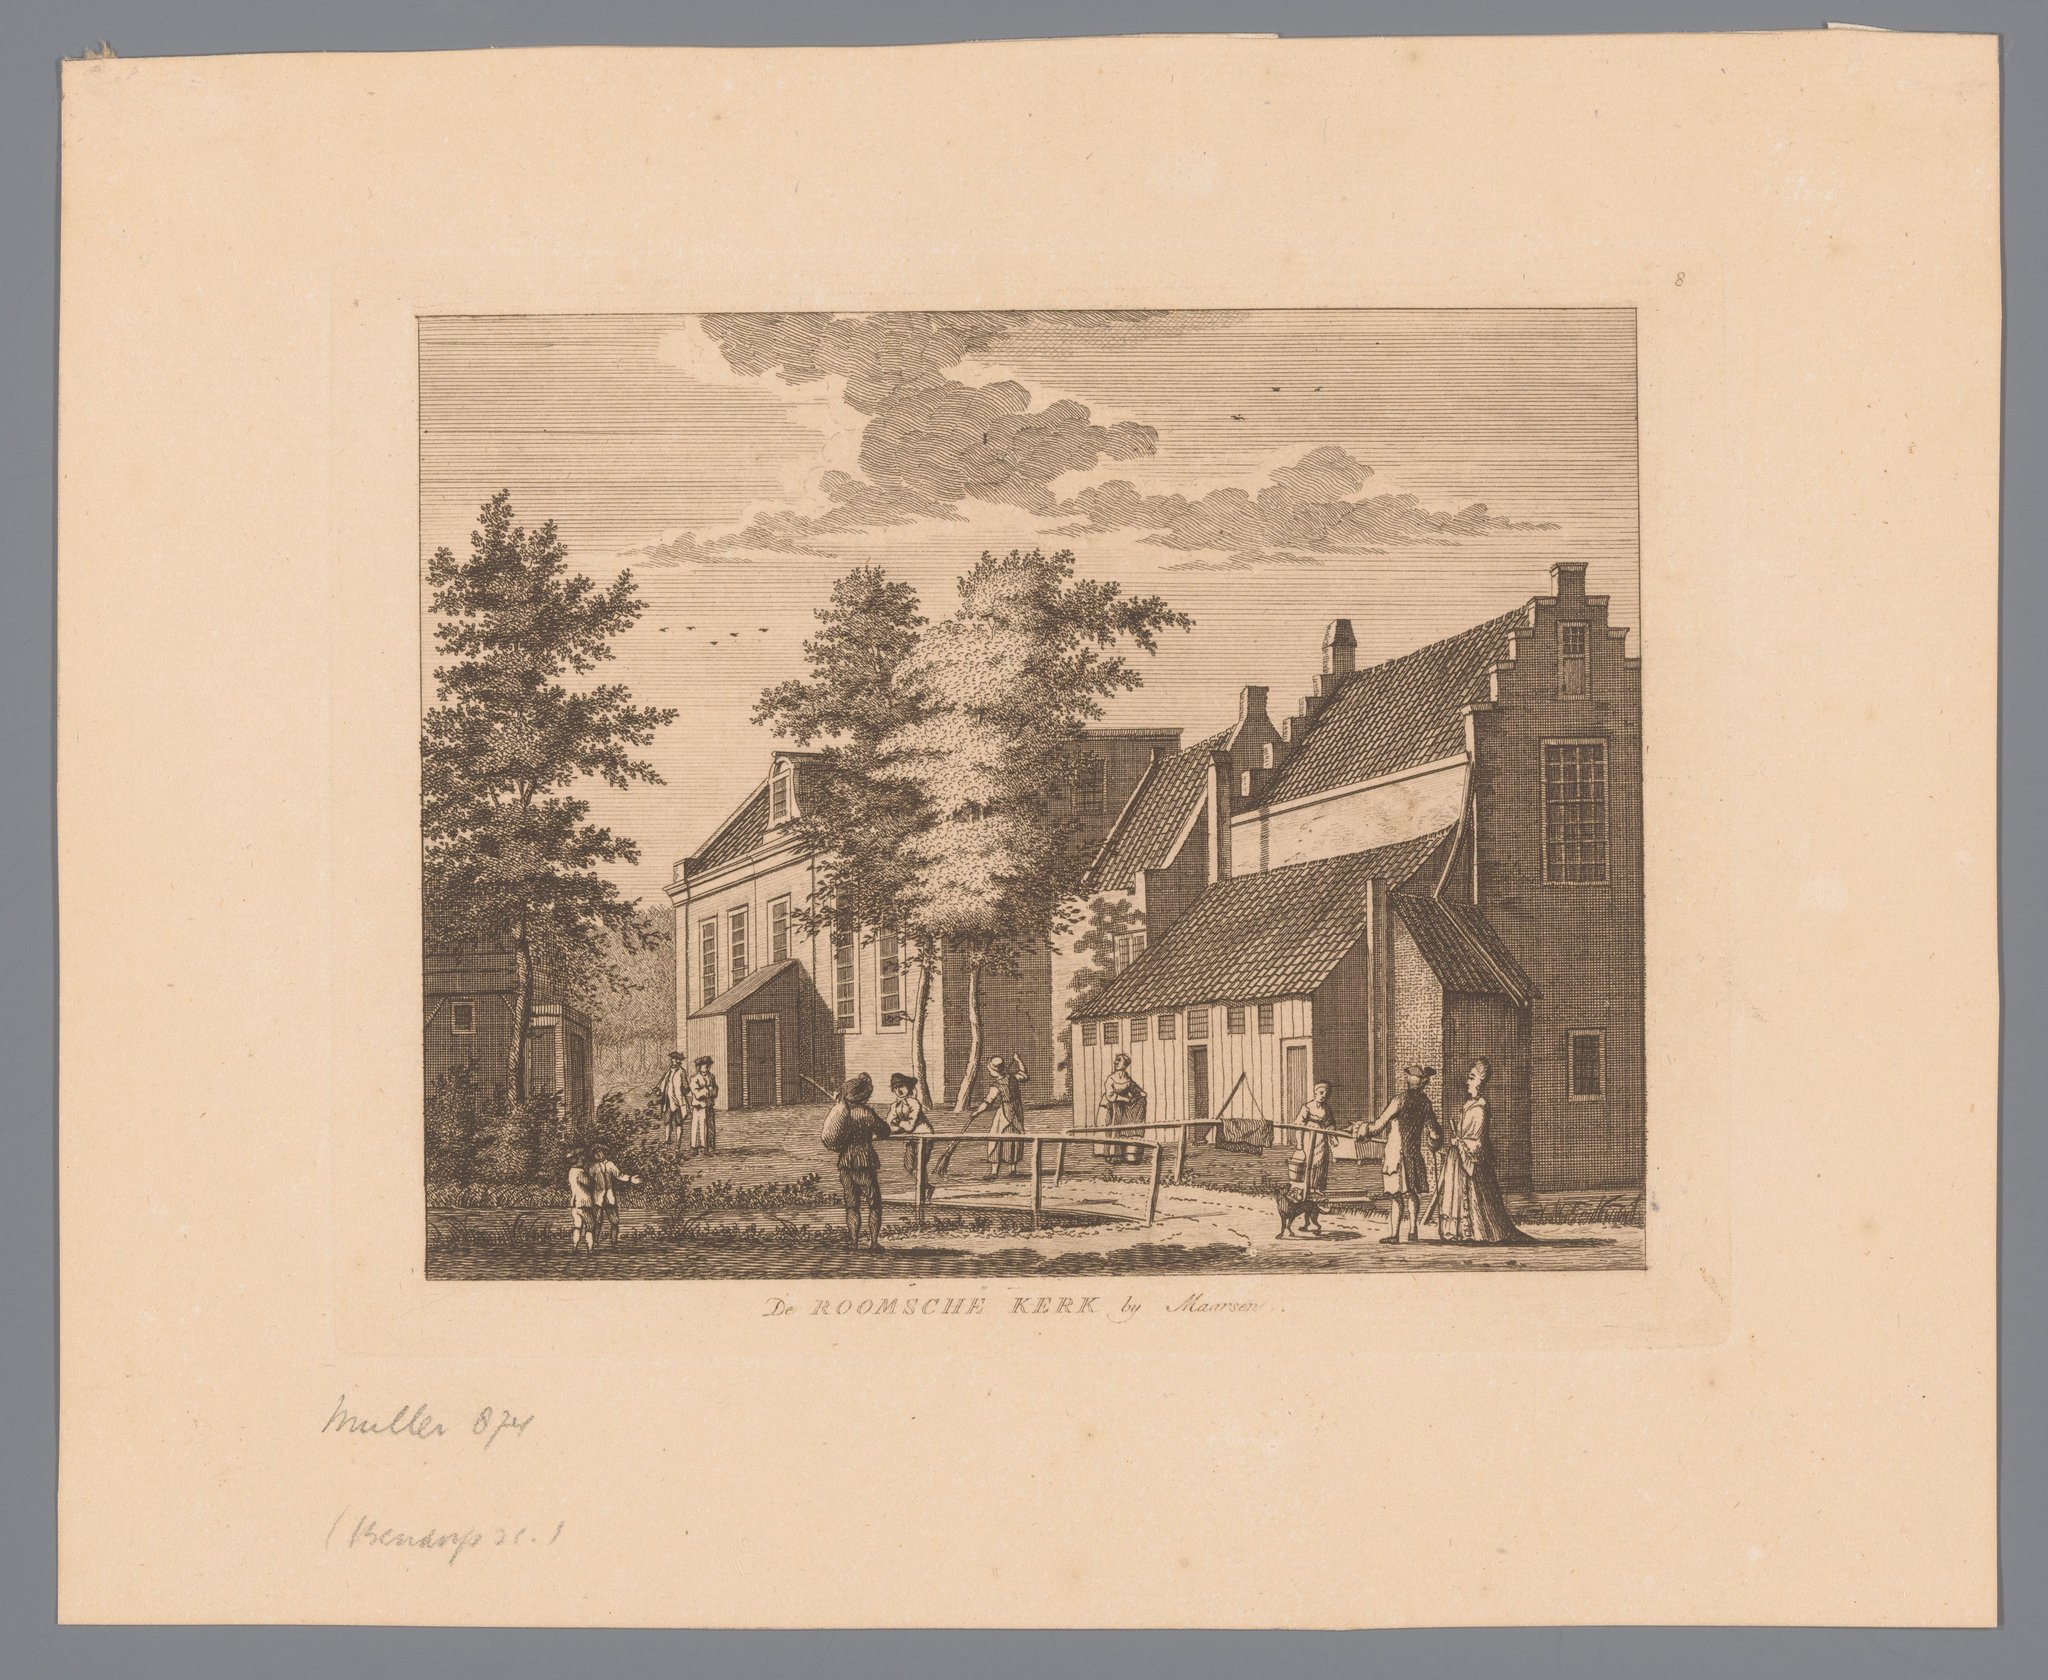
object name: print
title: Gezicht op de Rooms-katholieke kerk te Maarssen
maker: hermanus petrus schouten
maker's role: draughtsman, painter, print maker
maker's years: 1747-1822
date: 1775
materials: paper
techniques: etching, intaglio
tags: city-view, and landscape with man-made constructions, roman catholic church, maarssen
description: Deze prent is eerst verschenen in een reeks van twaalf prenten uitgegeven door Pierre Fouquet junior in de tweede helft van de achttiende eeuw. Deze reeks bestond uit prenten van: Spijk, Nieuwland, Heukelum (3x), Ensapijk, Leerdam, Deil, Gellicum, Asperen, Acquoy en Craijenstein (bij Tricht). Later zijn deze prenten gebruikt in: Gezigten van voornaame Hollandsche dorpen. Amsterdam: Evert Maaskamp, [ca. 1775-1800].